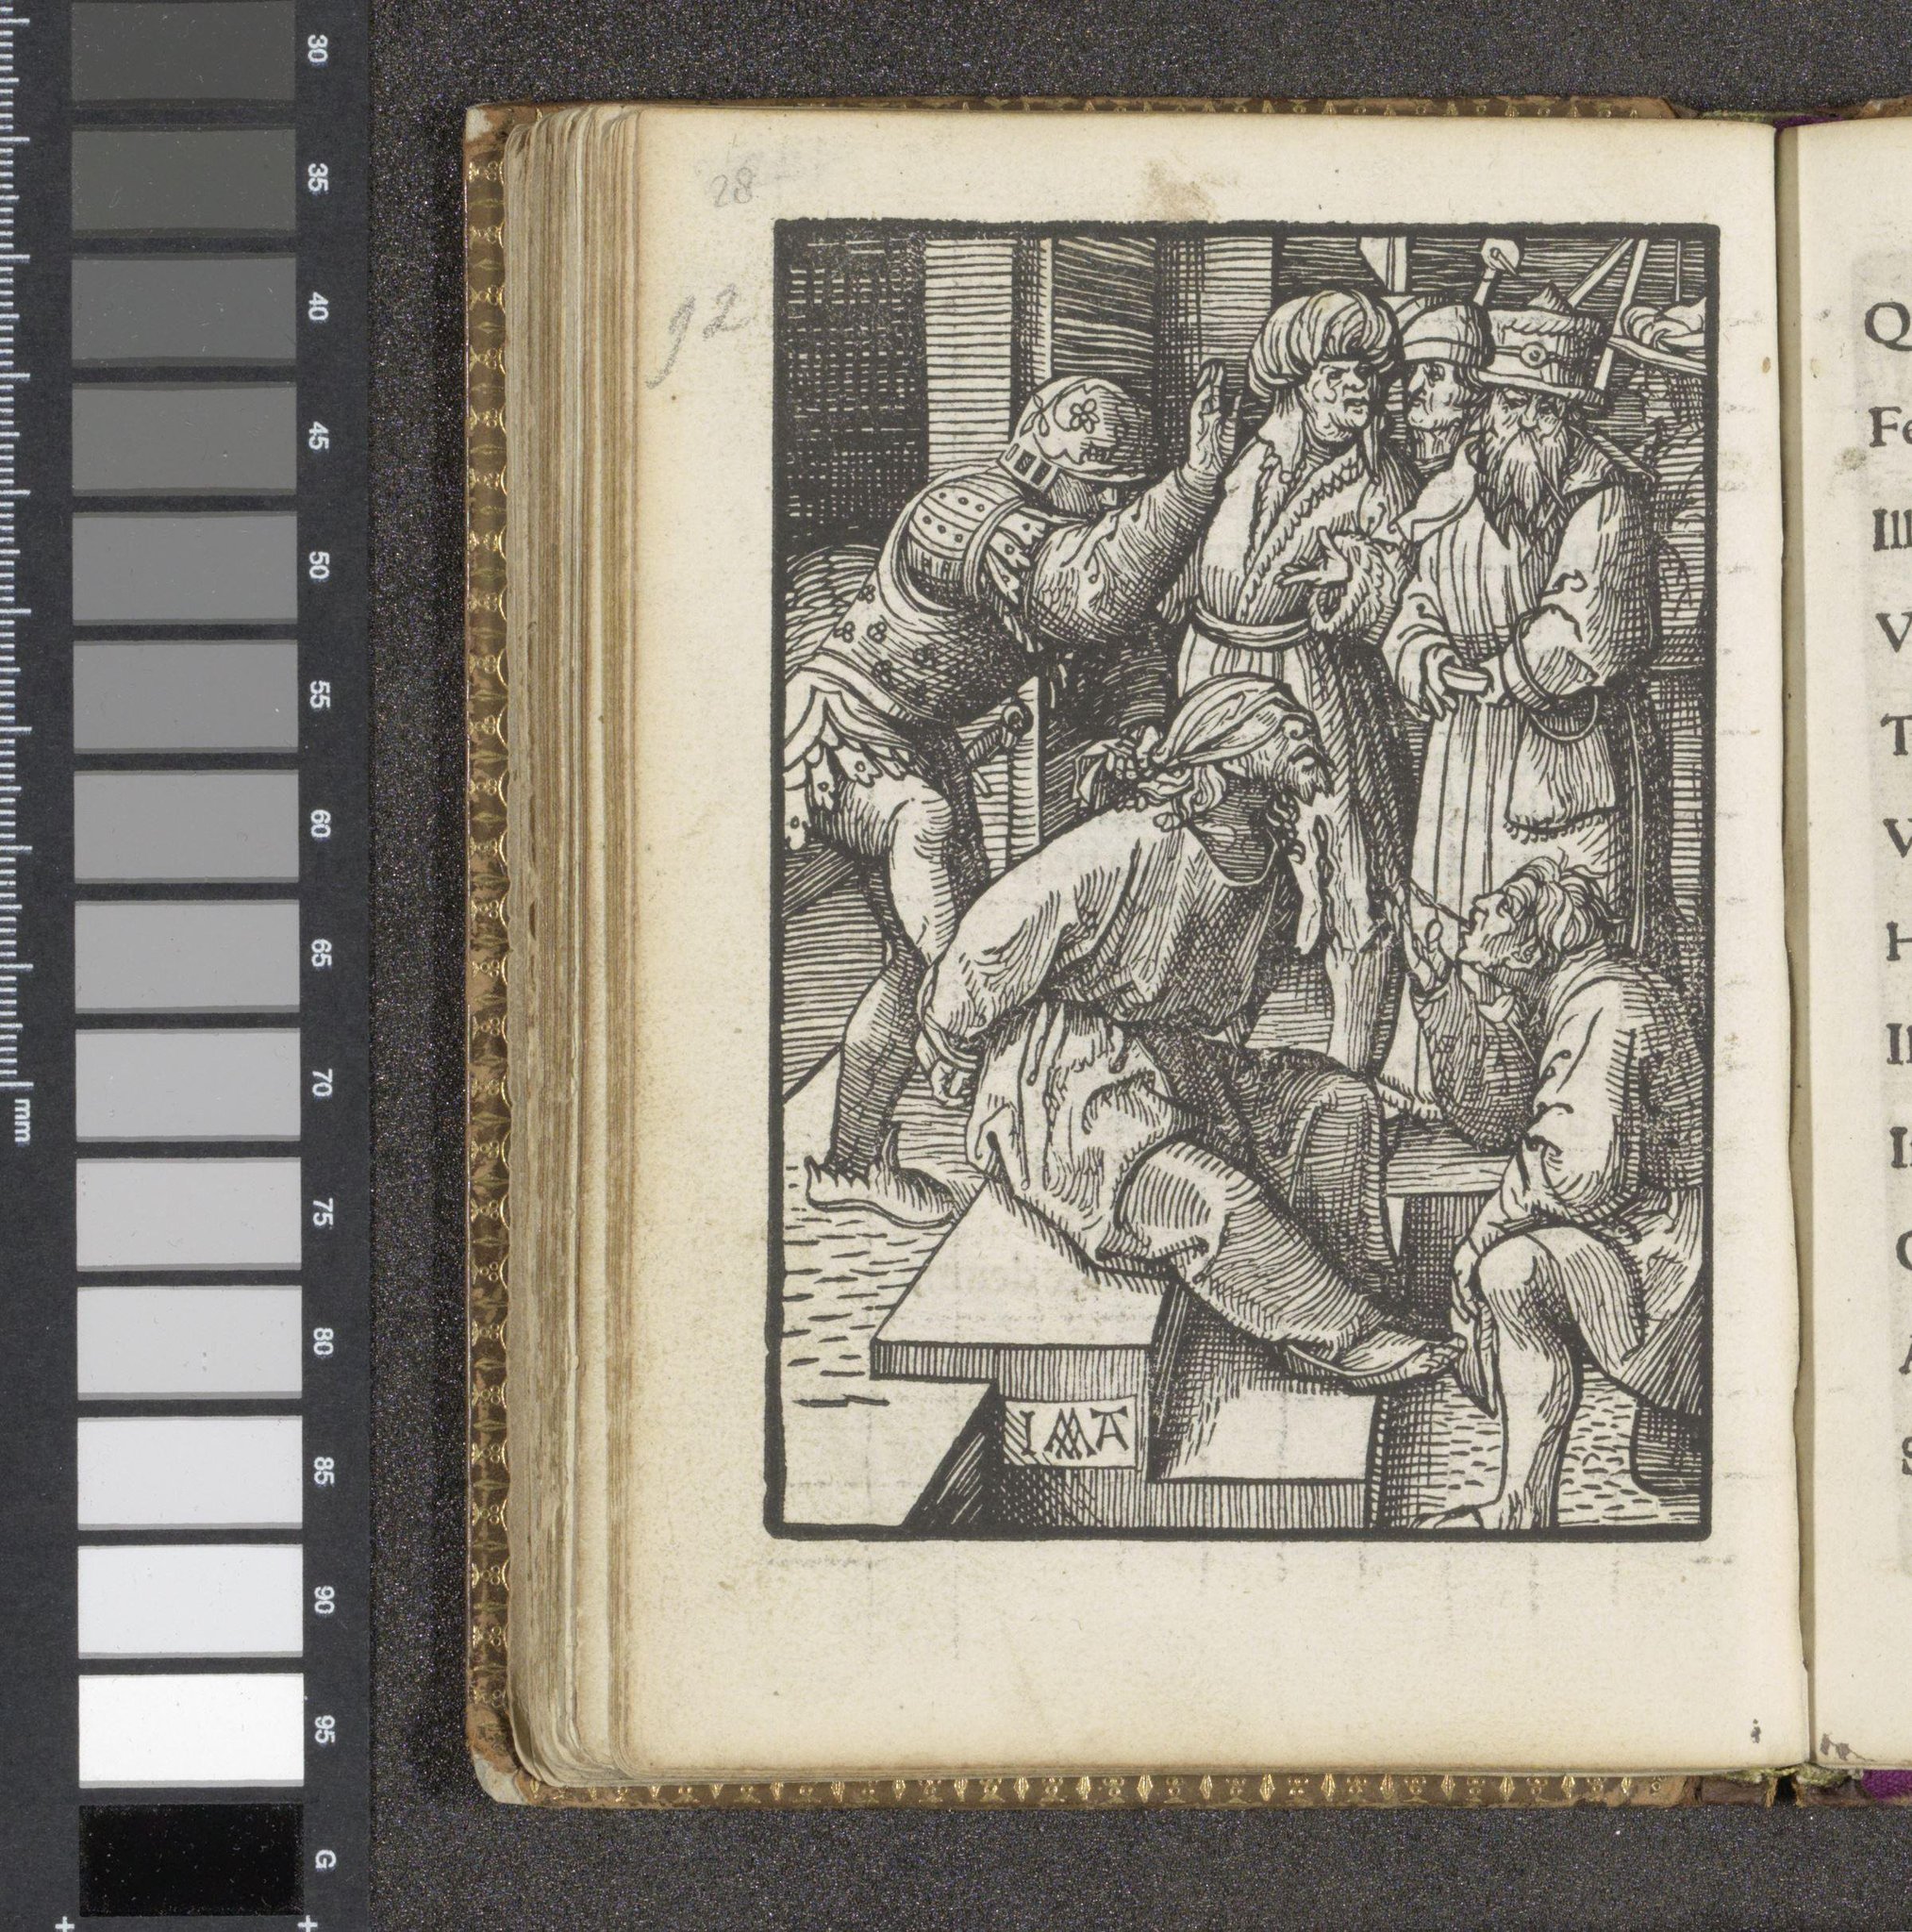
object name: print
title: Bespotting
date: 1523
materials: paper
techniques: woodcut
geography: amsterdam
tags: mockings of christ, who may be blindfolded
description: Christus zit geblinddoekt en met vastgebonden handen op de grond. Een man slaat hem, een ander spuugt in zijn gezicht. Prent maakt deel uit van een boek.